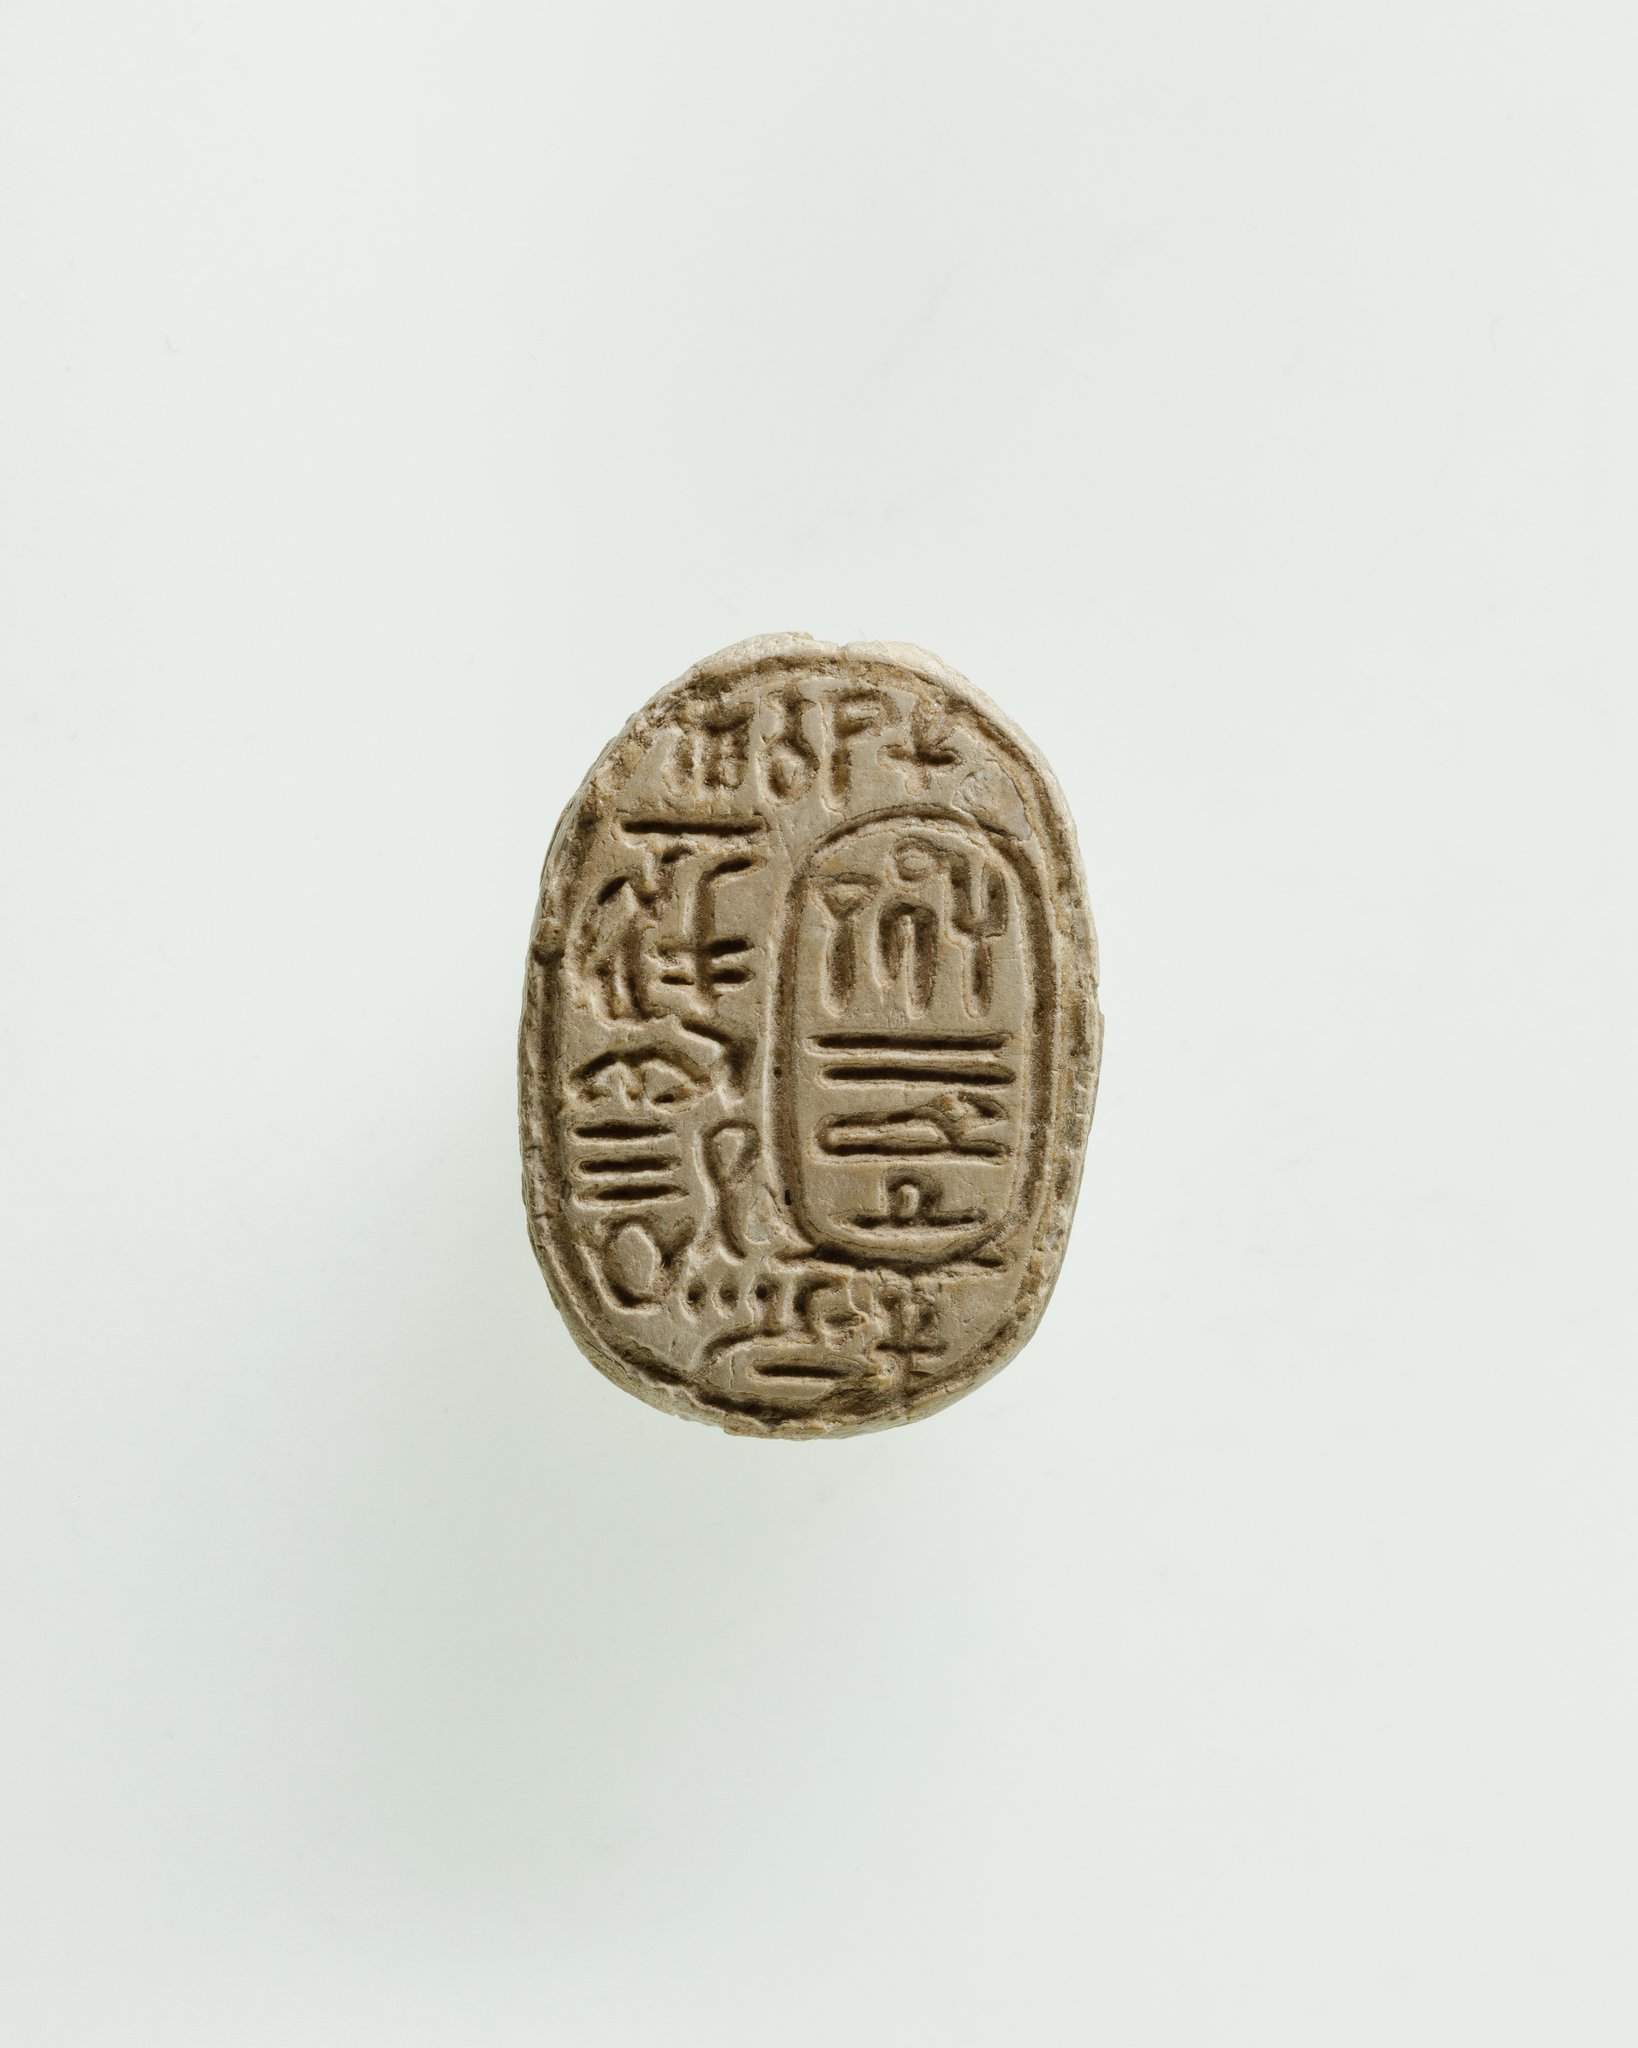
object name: scarab, sebekhotep iii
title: Scarab of King Sekhemre Sewadjtawy Sebekhotep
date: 1748-1741 BCE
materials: stone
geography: egypt